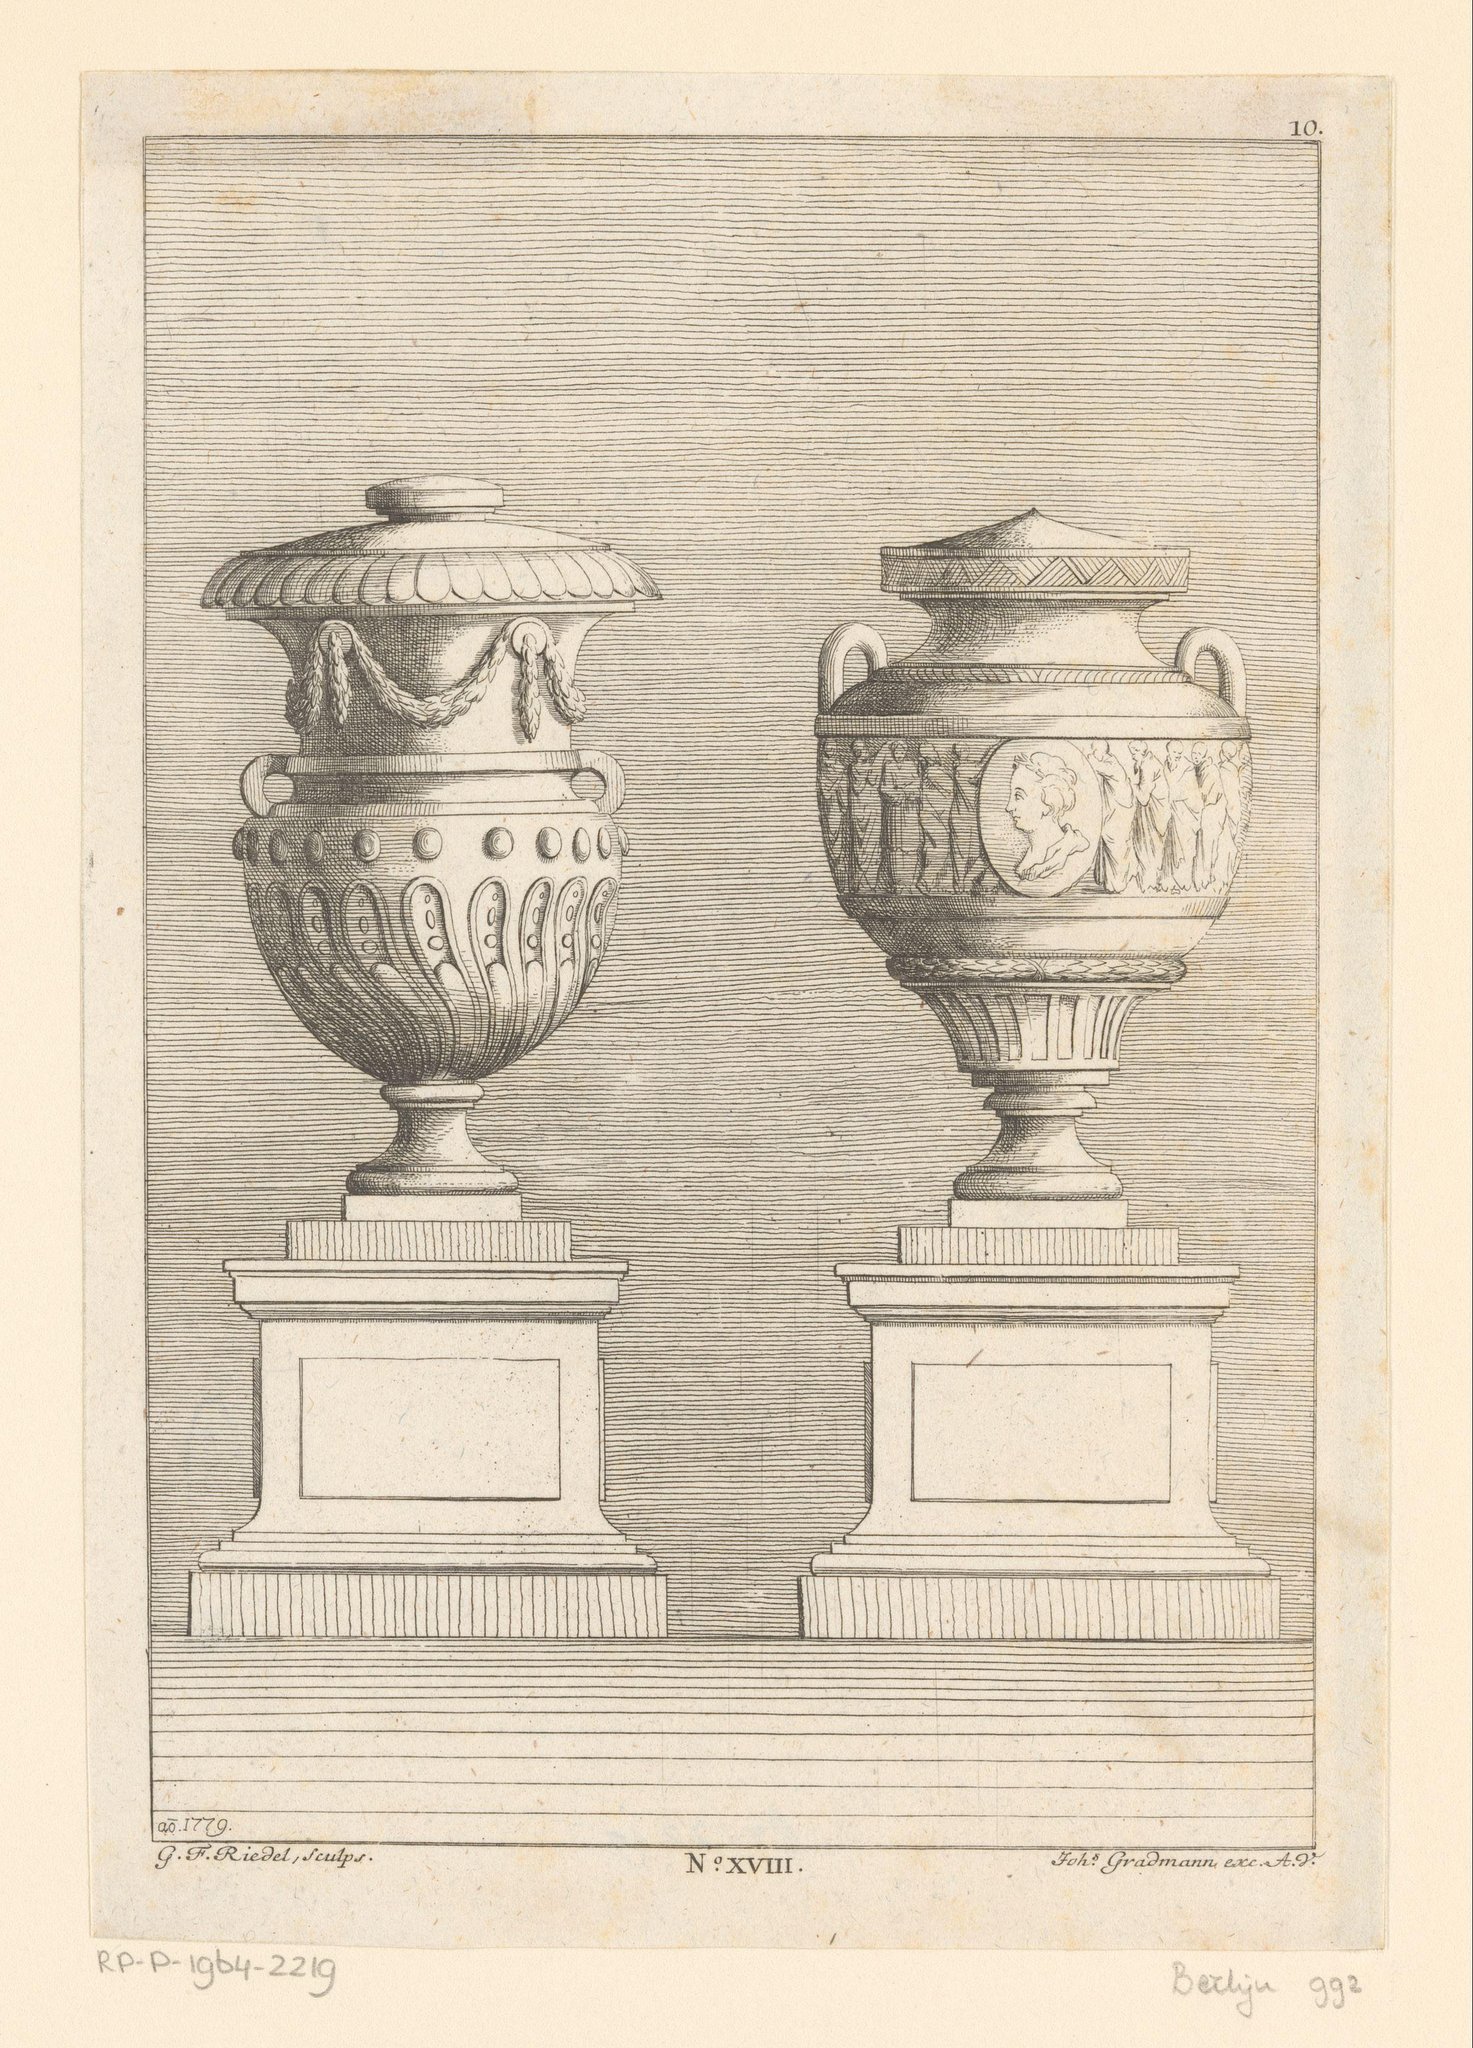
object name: print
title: Twee urnen op voetstukken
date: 1779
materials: paper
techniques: etching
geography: augsburg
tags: pedestal of a piece of sculpture (perhaps in the form of a herm), urn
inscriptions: collector's mark: Lugt 2760, collector's mark: Lugt 2228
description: Twee urnen gedecoreerd met een guirlande, een ovaal medaillon en figuren, op voetstukken. Uitgeversnummer XVIII.